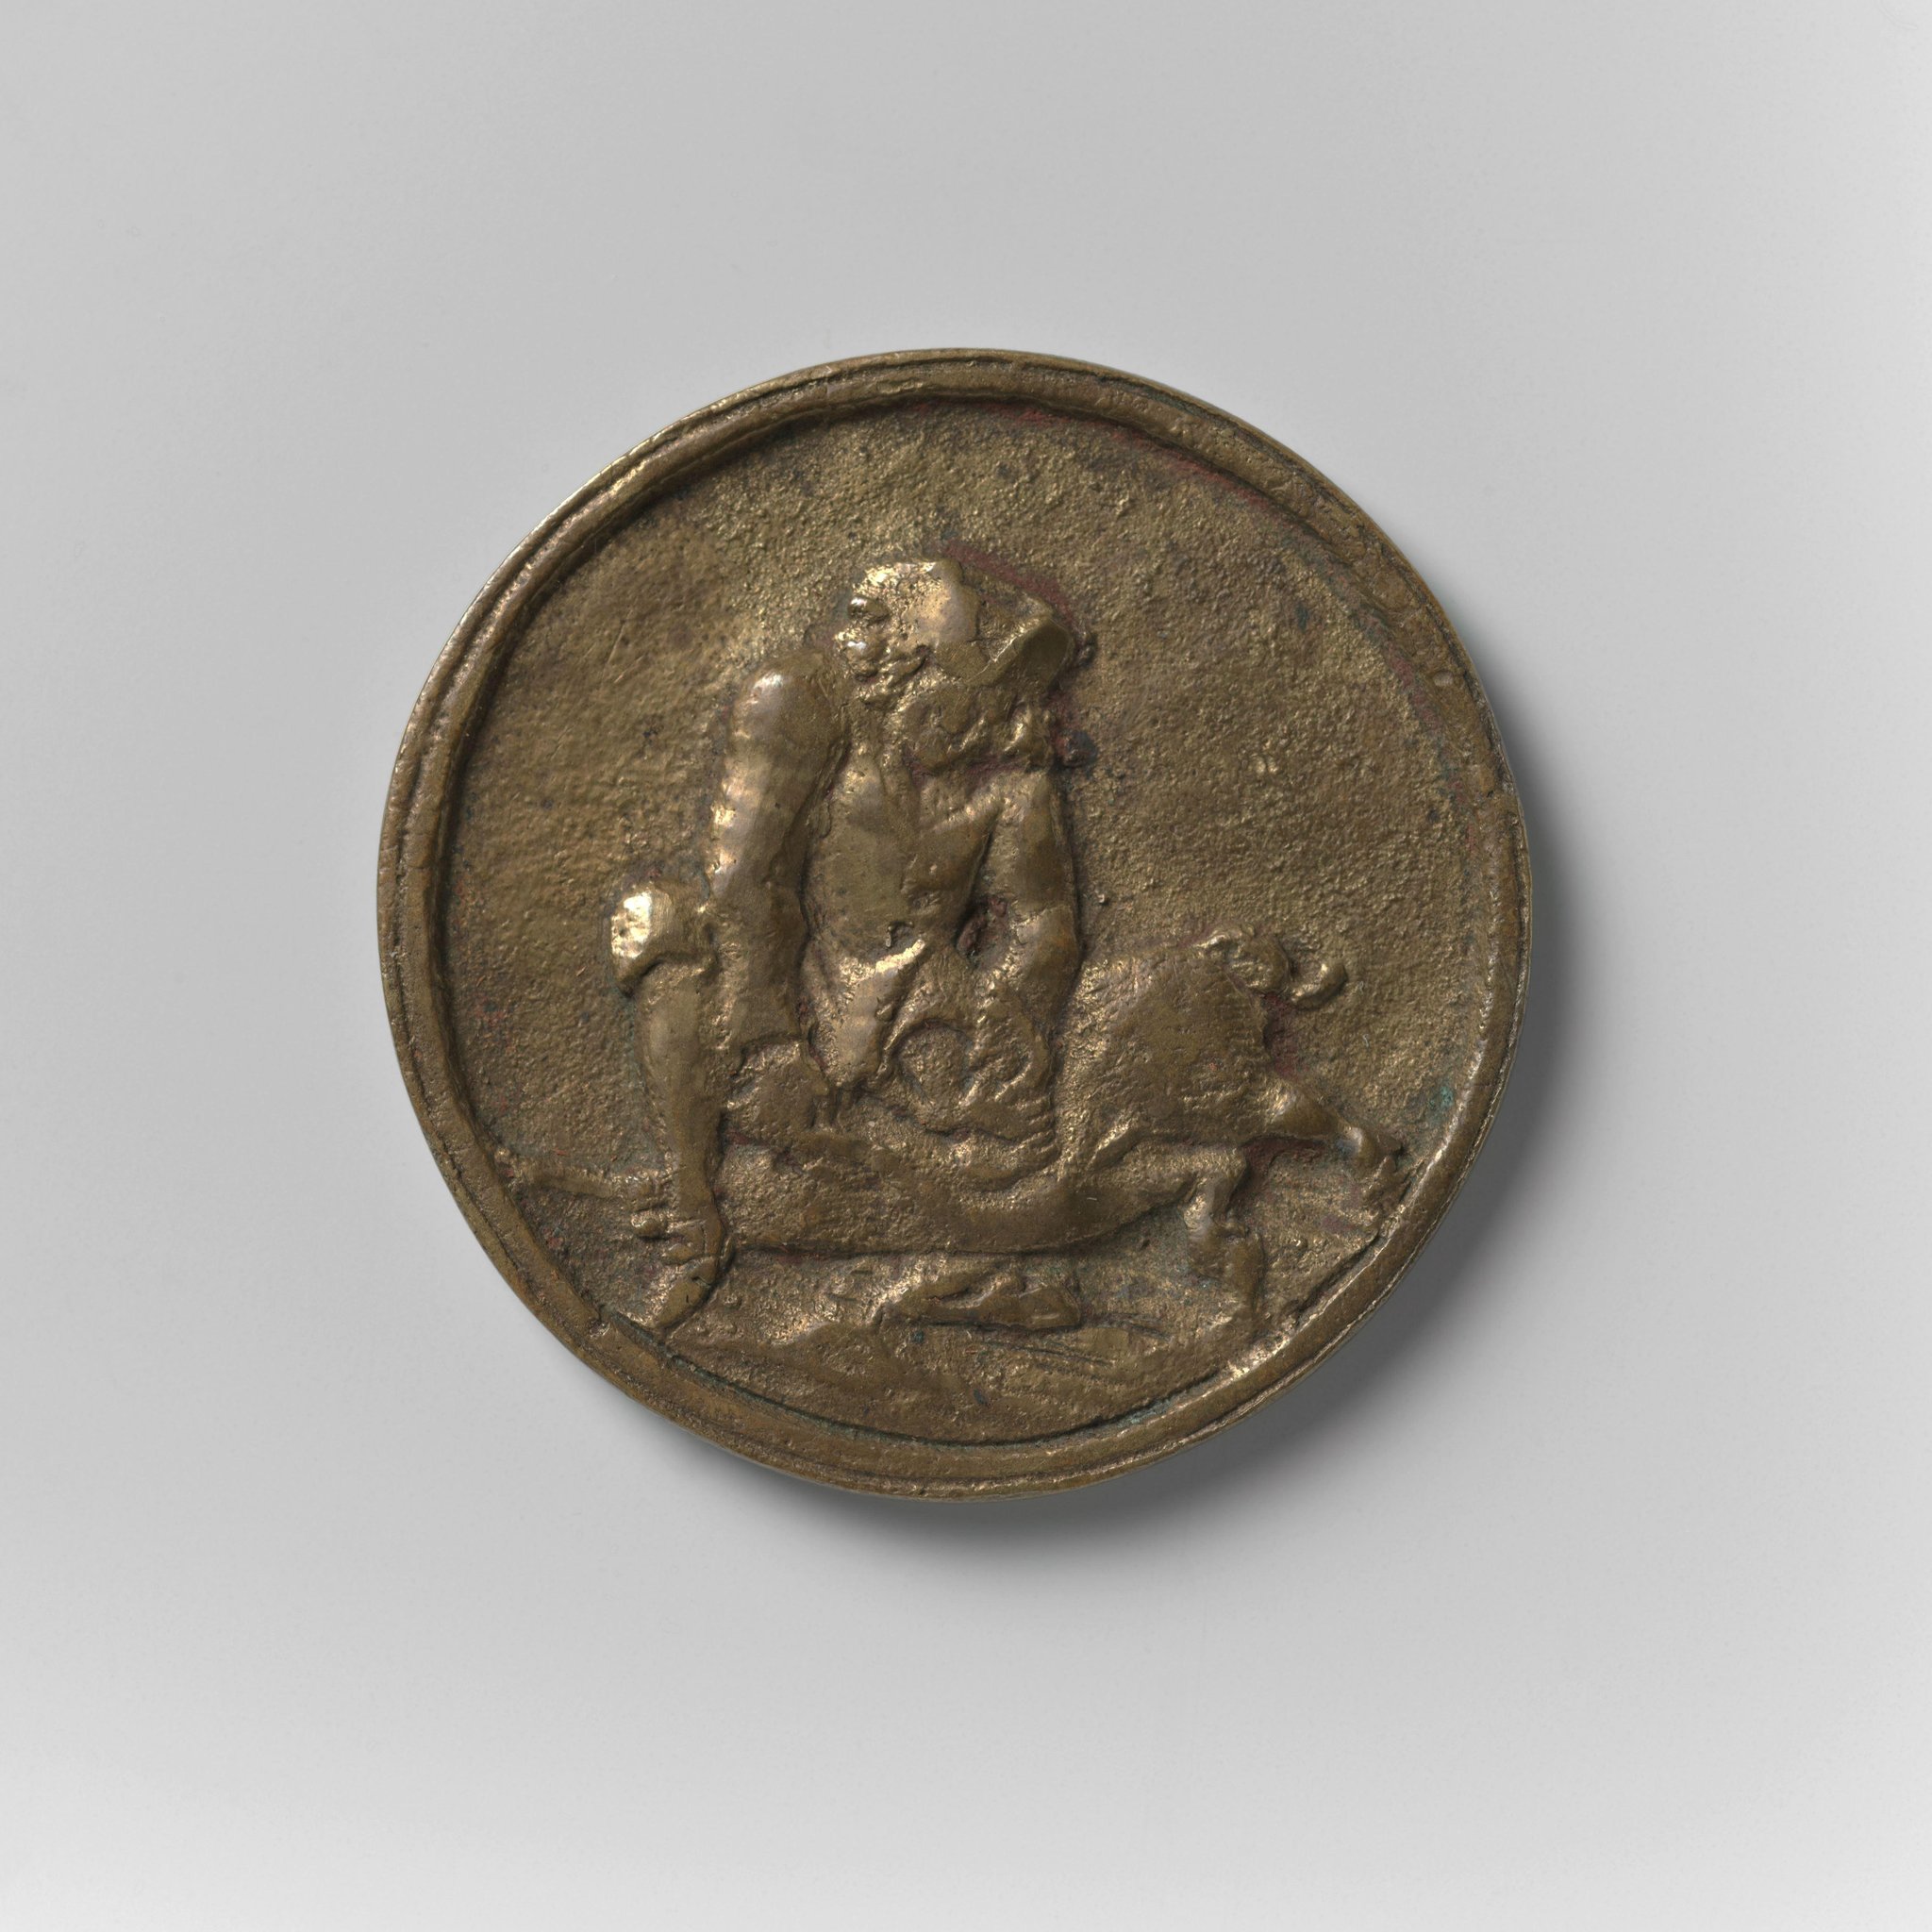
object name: history medal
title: Presentiepenning van het Spek- en Varkensslagersgilde te Amsterdam, 1751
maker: ludolph cloppenburg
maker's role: caster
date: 1751-1781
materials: brass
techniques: casting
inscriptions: inscription: ‘HARMANUS / PIENING / 1781’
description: Gegoten messing penning, op de voorzijde een varkensslager met varken, op de keerzijde een gekroond wapenschild Amsterdam met dragers boven een inscriptieruimte, op naam van Harmanus Piening 1781